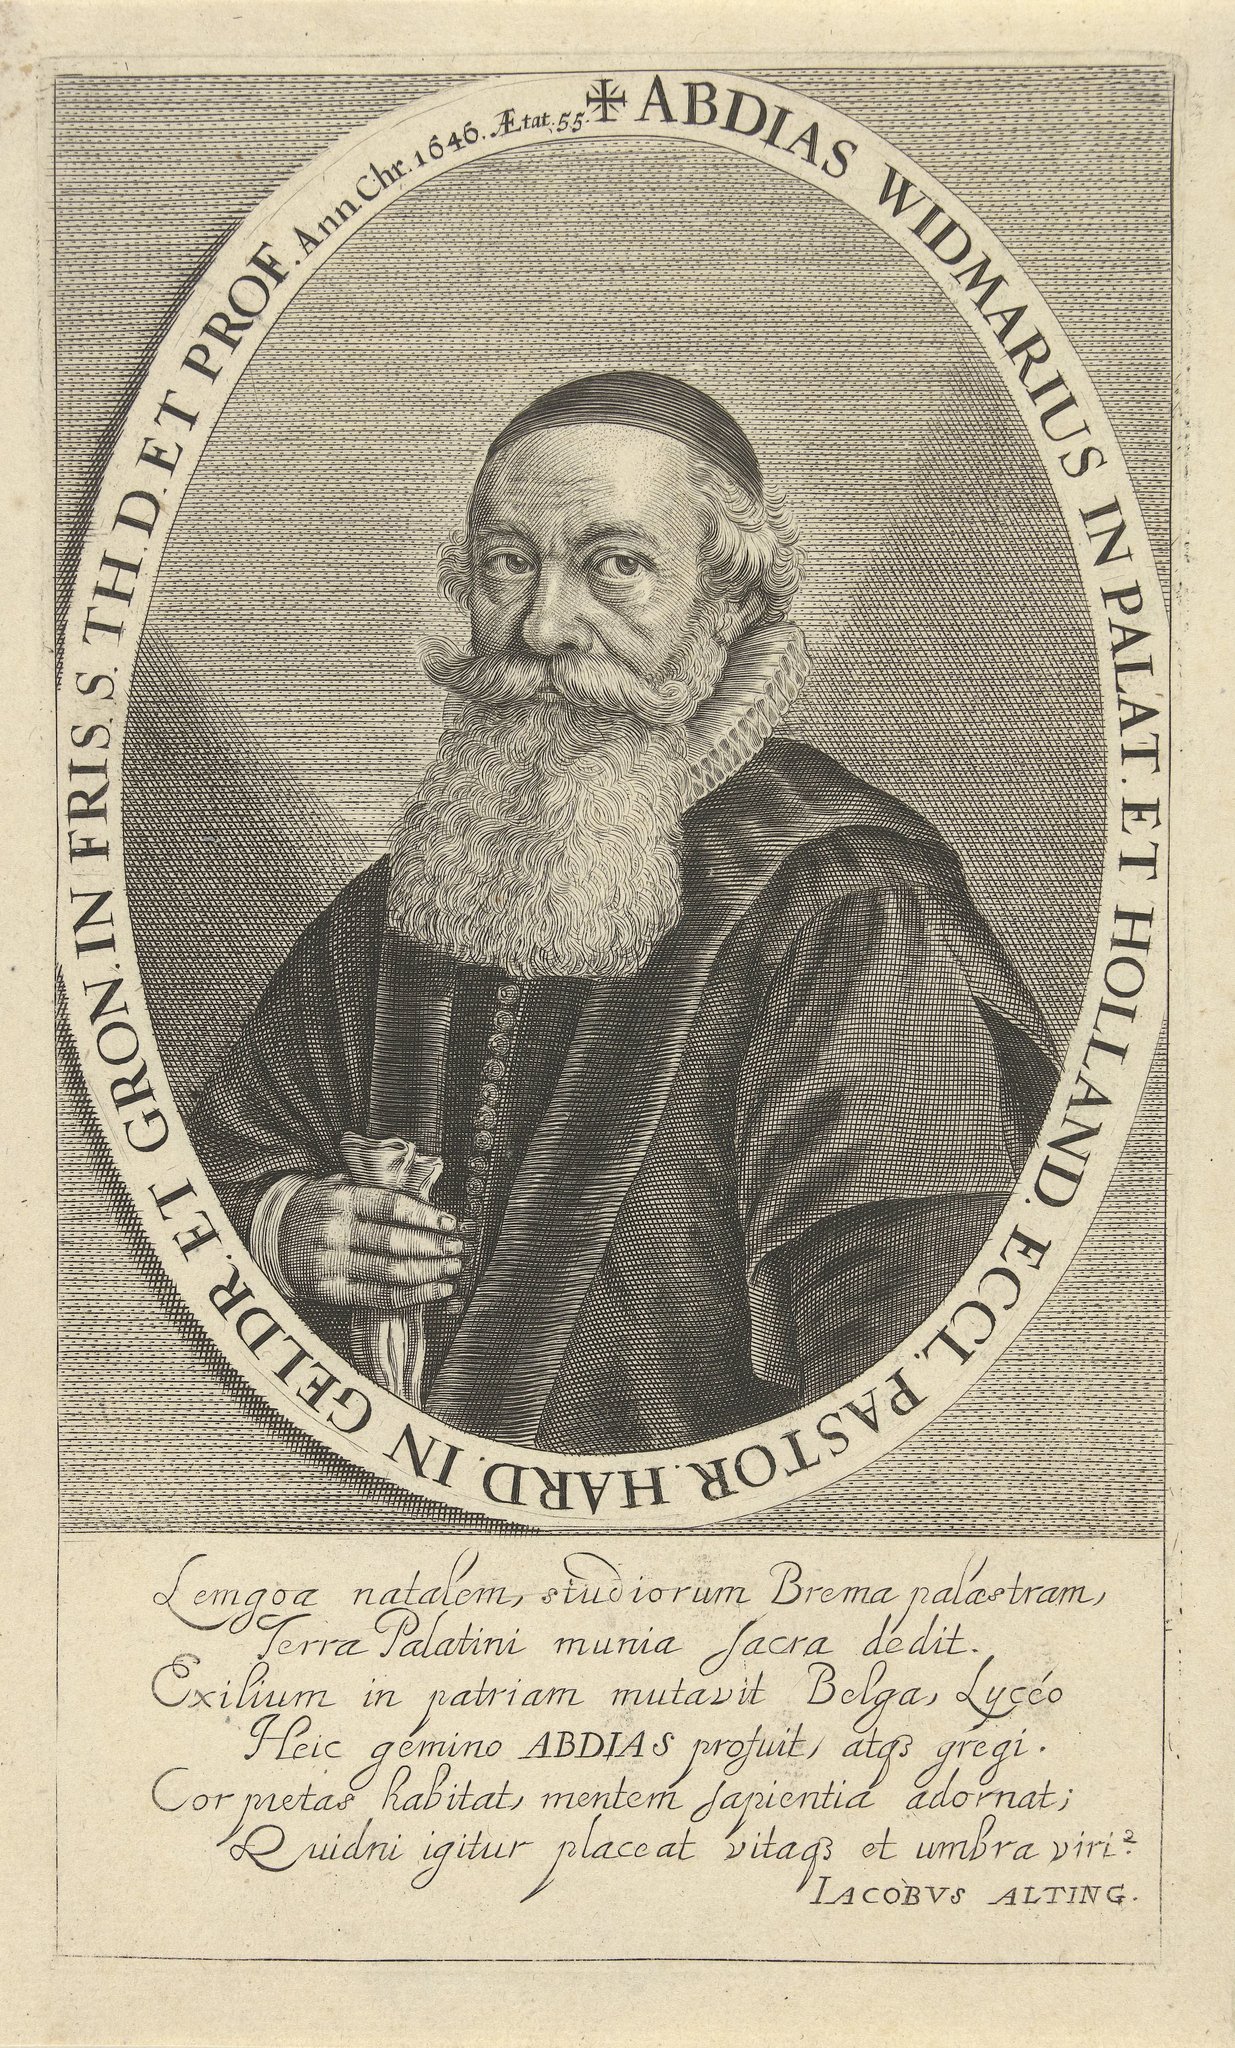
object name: print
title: Portret van Abdias Widmarius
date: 1654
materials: paper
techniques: engraving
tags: predikant, theoloog, professor, abdias widmarius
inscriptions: collector's mark: Lugt 2228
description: Portretbuste in ovaal naar links van Abdias Widmarius, predikant en hoogleraar in de theologie te Groningen, met kalot. Op de ovale omlijsting staat een randschrift in Latijn, in de marge een zesregelig Latijns vers.